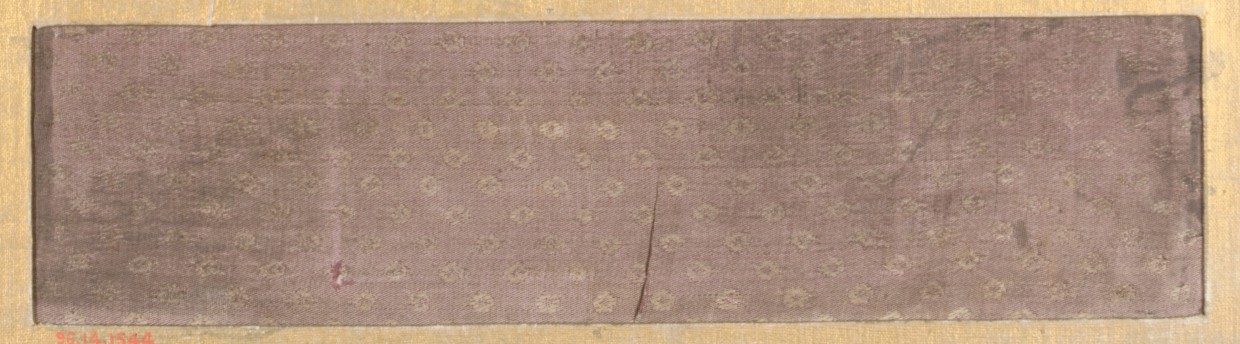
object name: piece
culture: japanese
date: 1701-1900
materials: silk